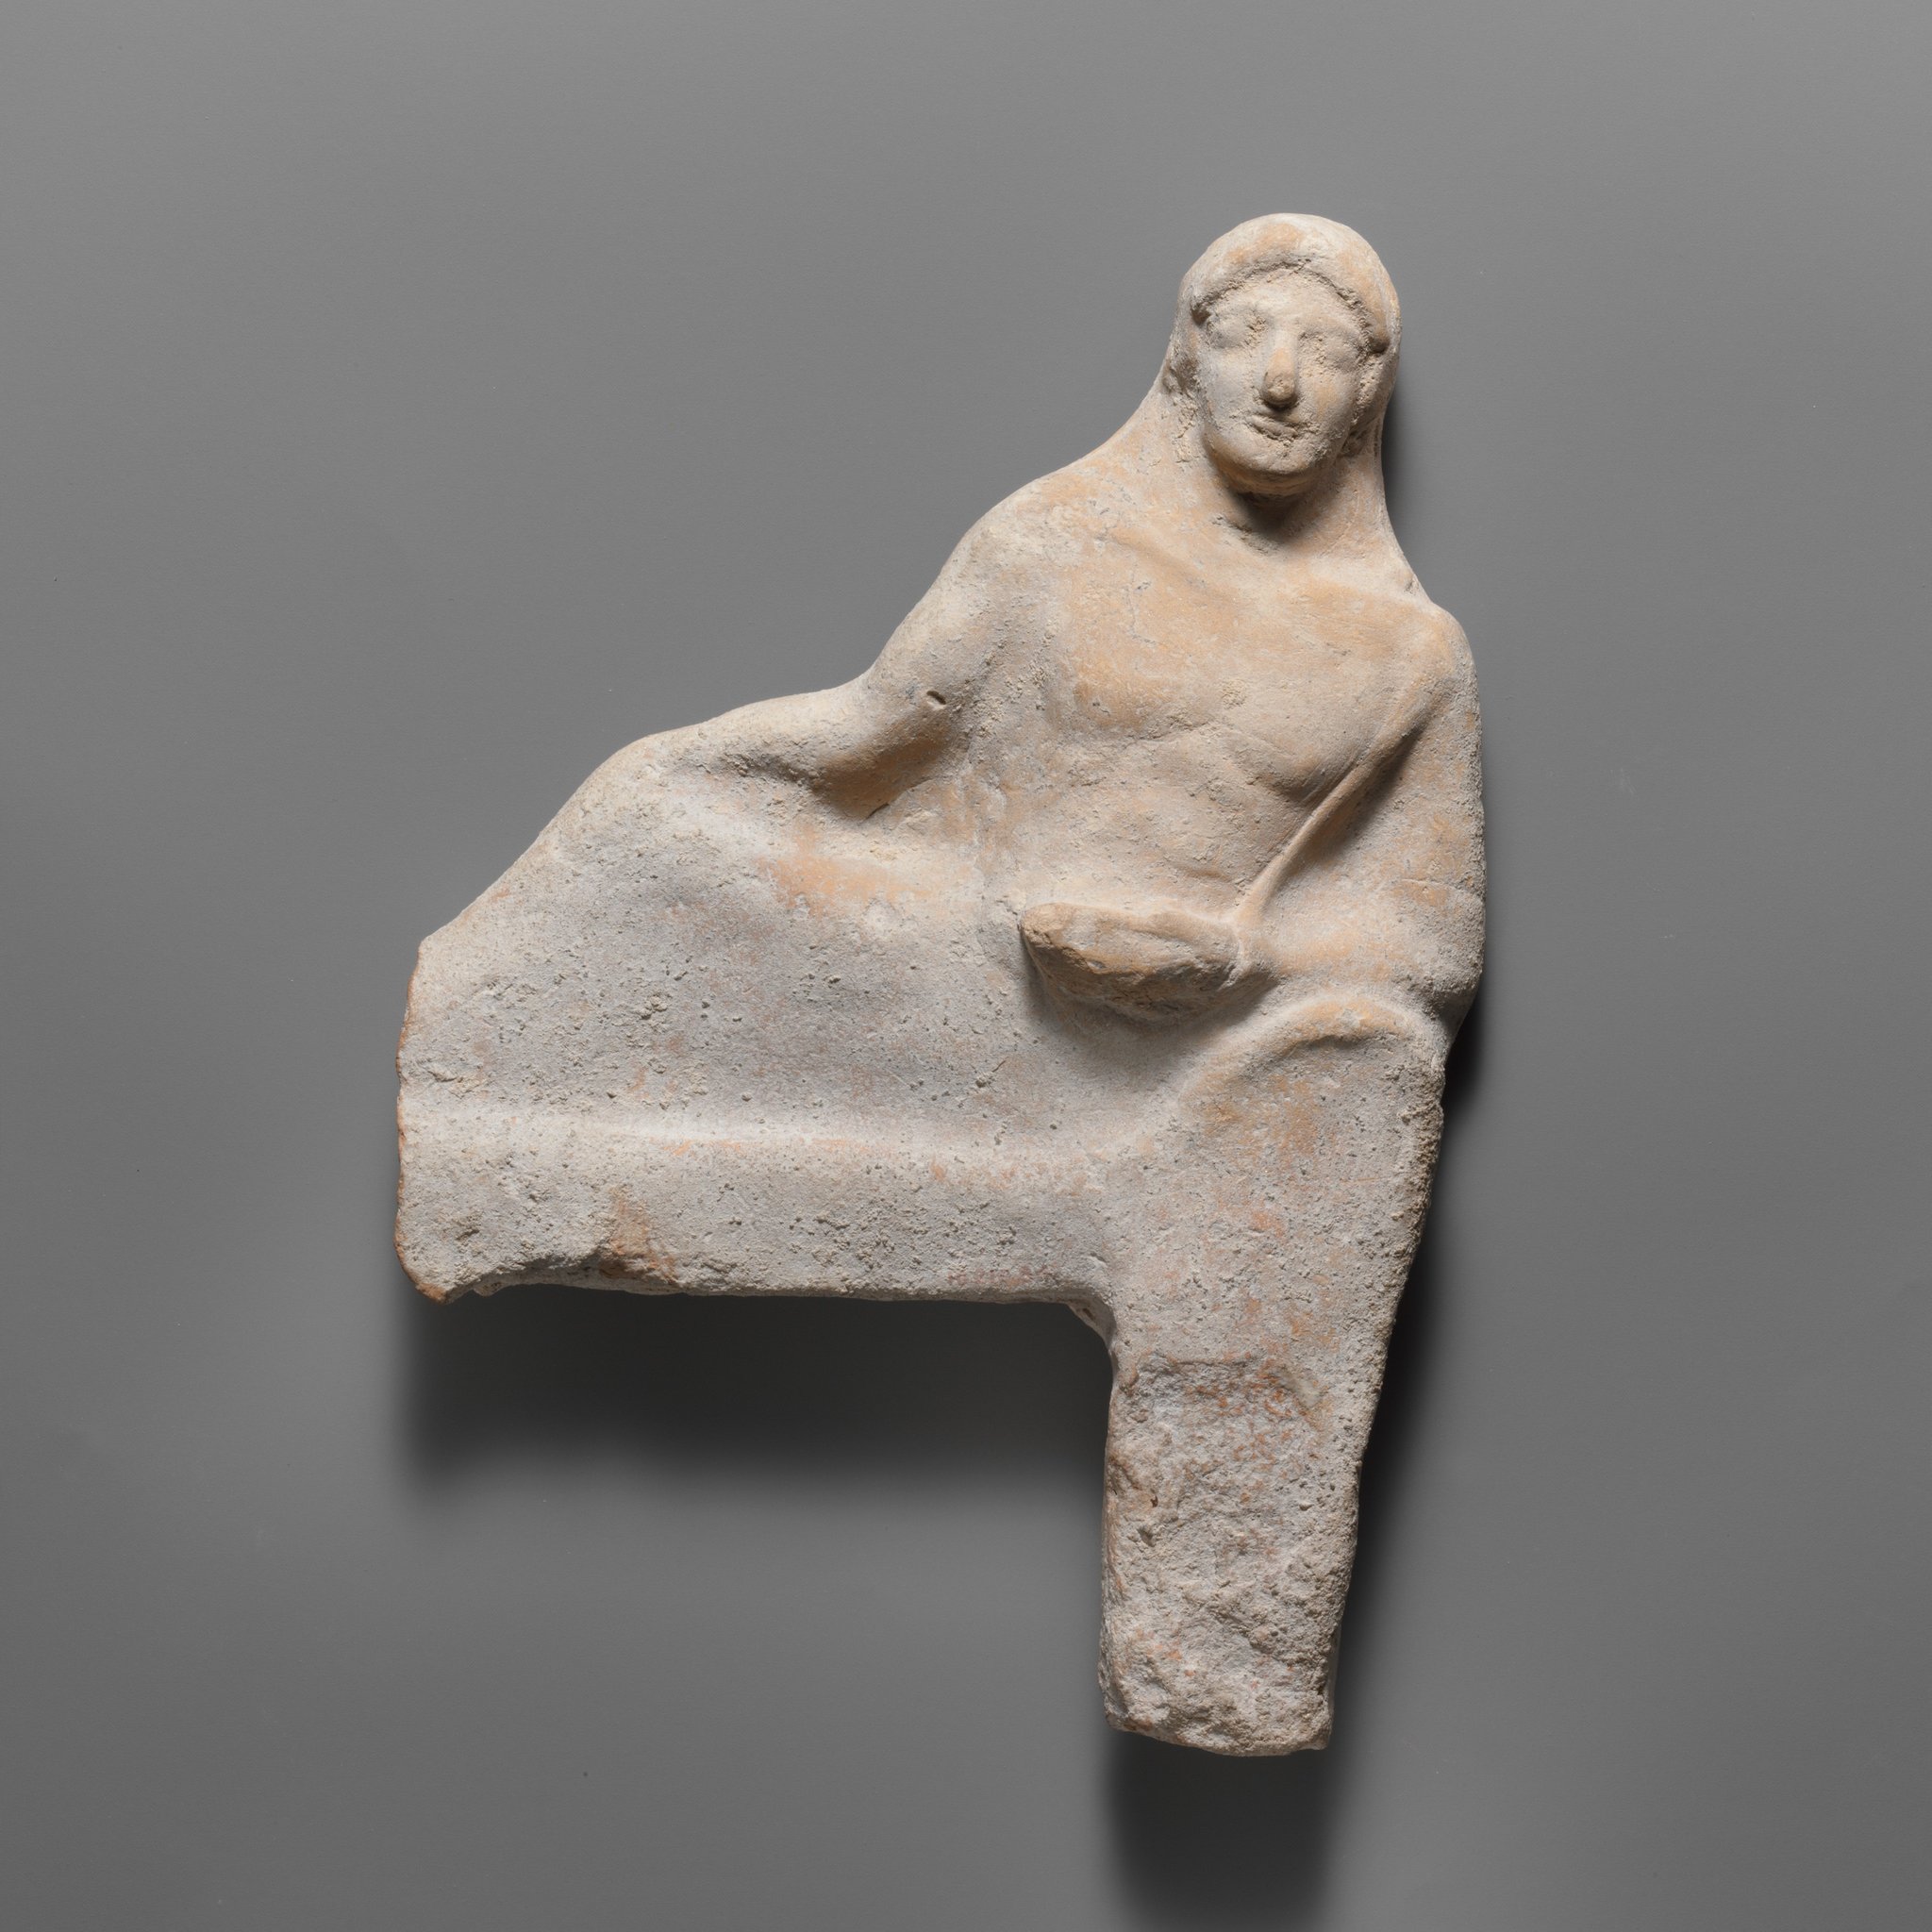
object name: statue of a figure reclining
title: Fragmentary terracotta relief of a reclining figure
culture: greek, south italian, tarentine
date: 534-468 BCE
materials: terracotta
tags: men